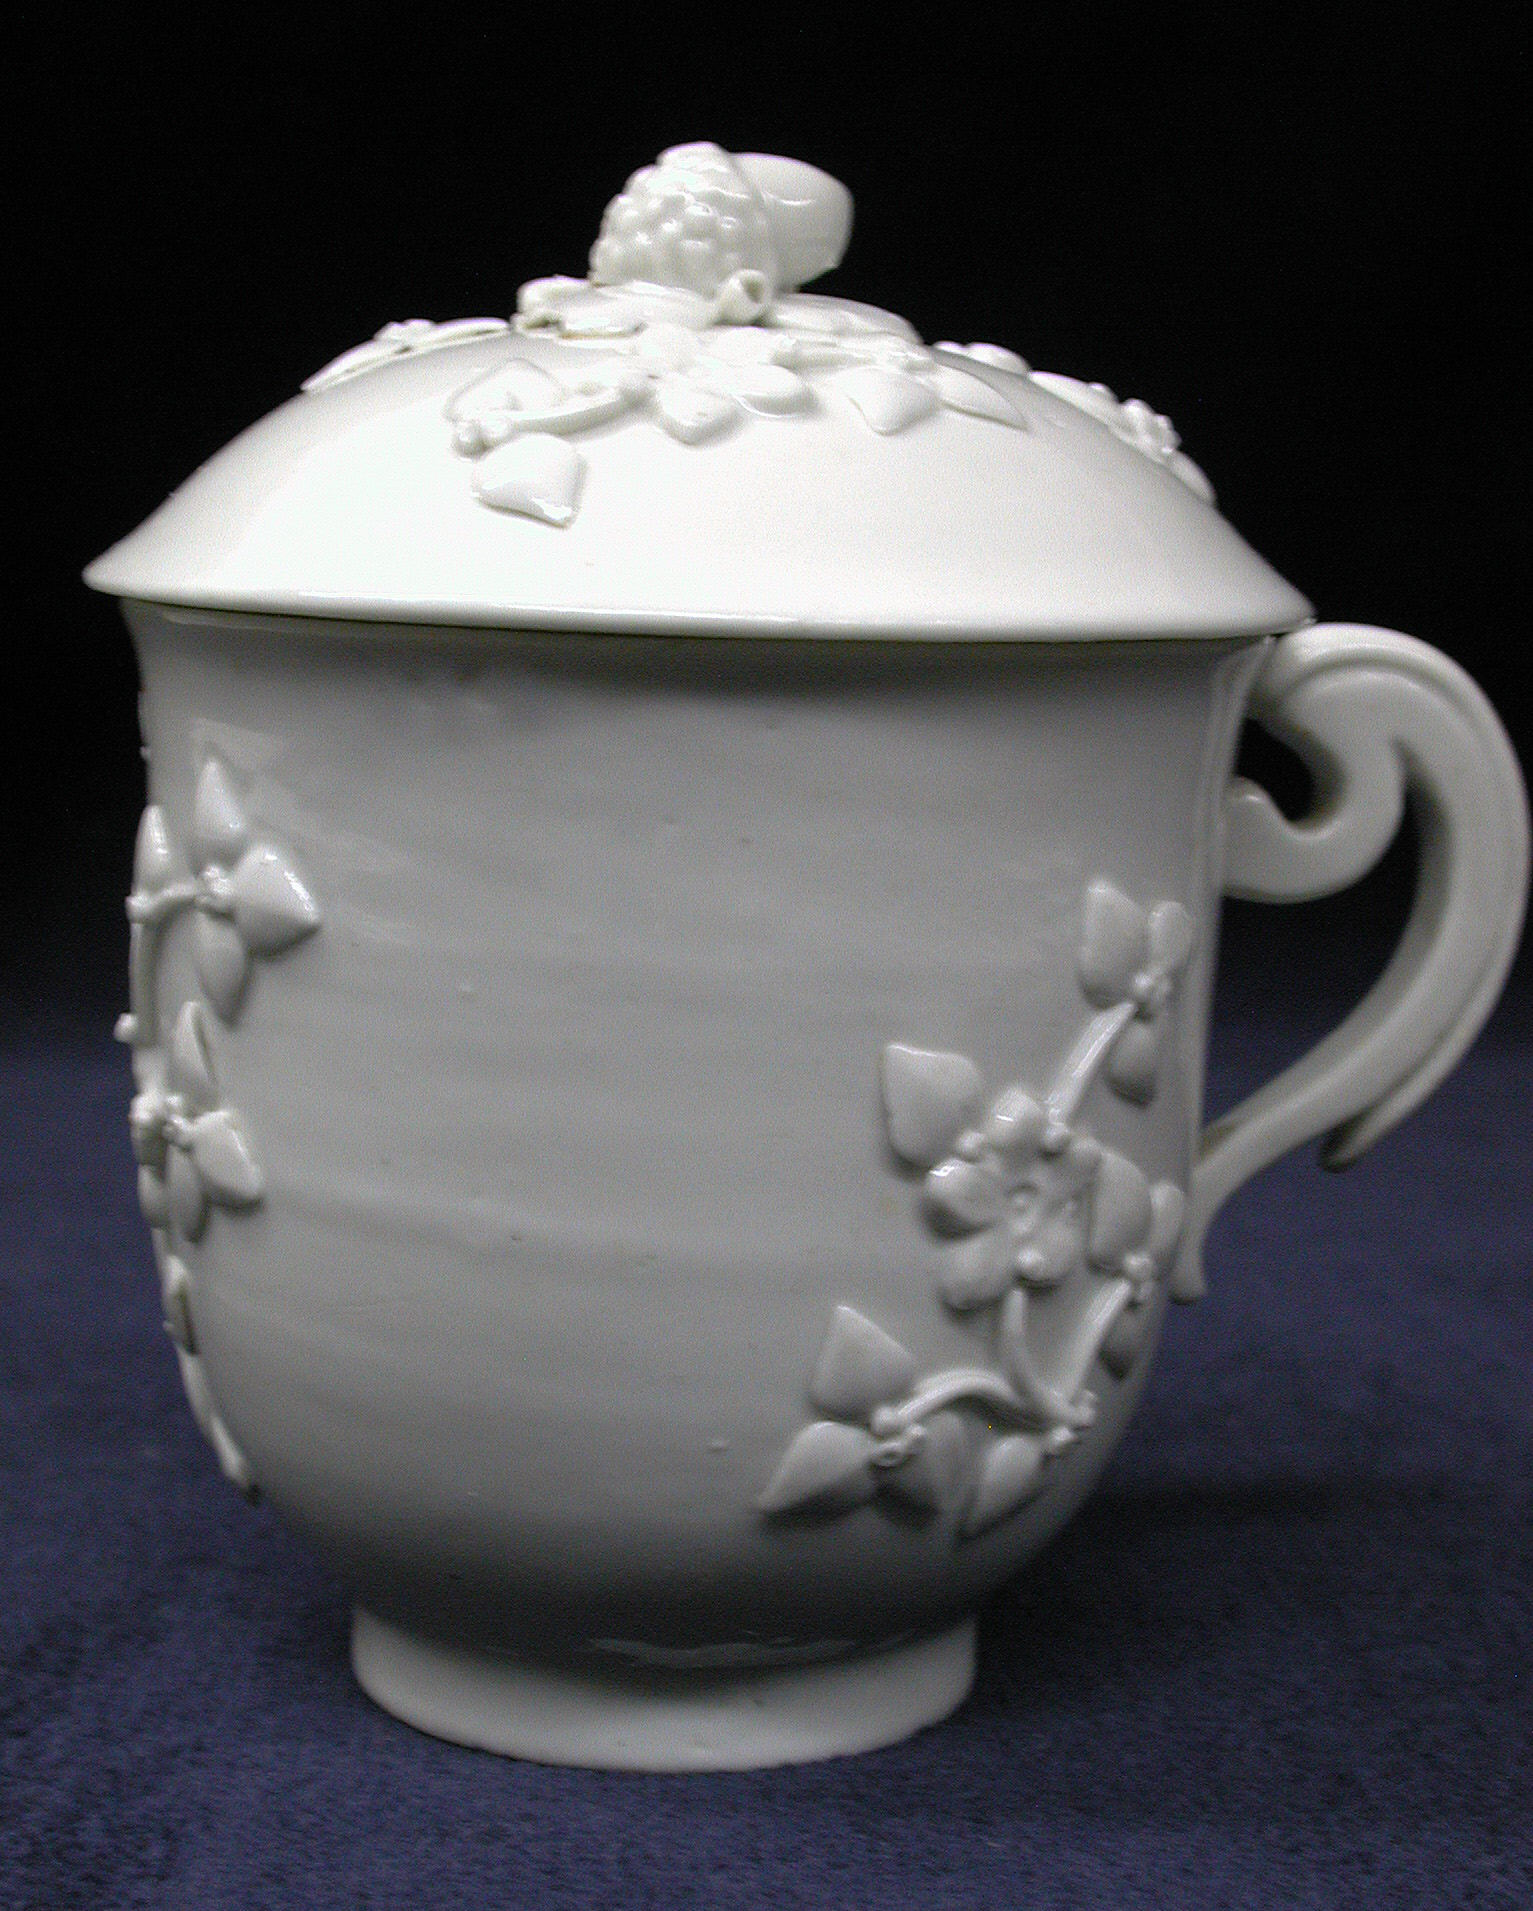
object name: cup with cover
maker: chantilly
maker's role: factory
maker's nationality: french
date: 1735-1740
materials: soft paste porcelain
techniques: glazing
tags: flowers